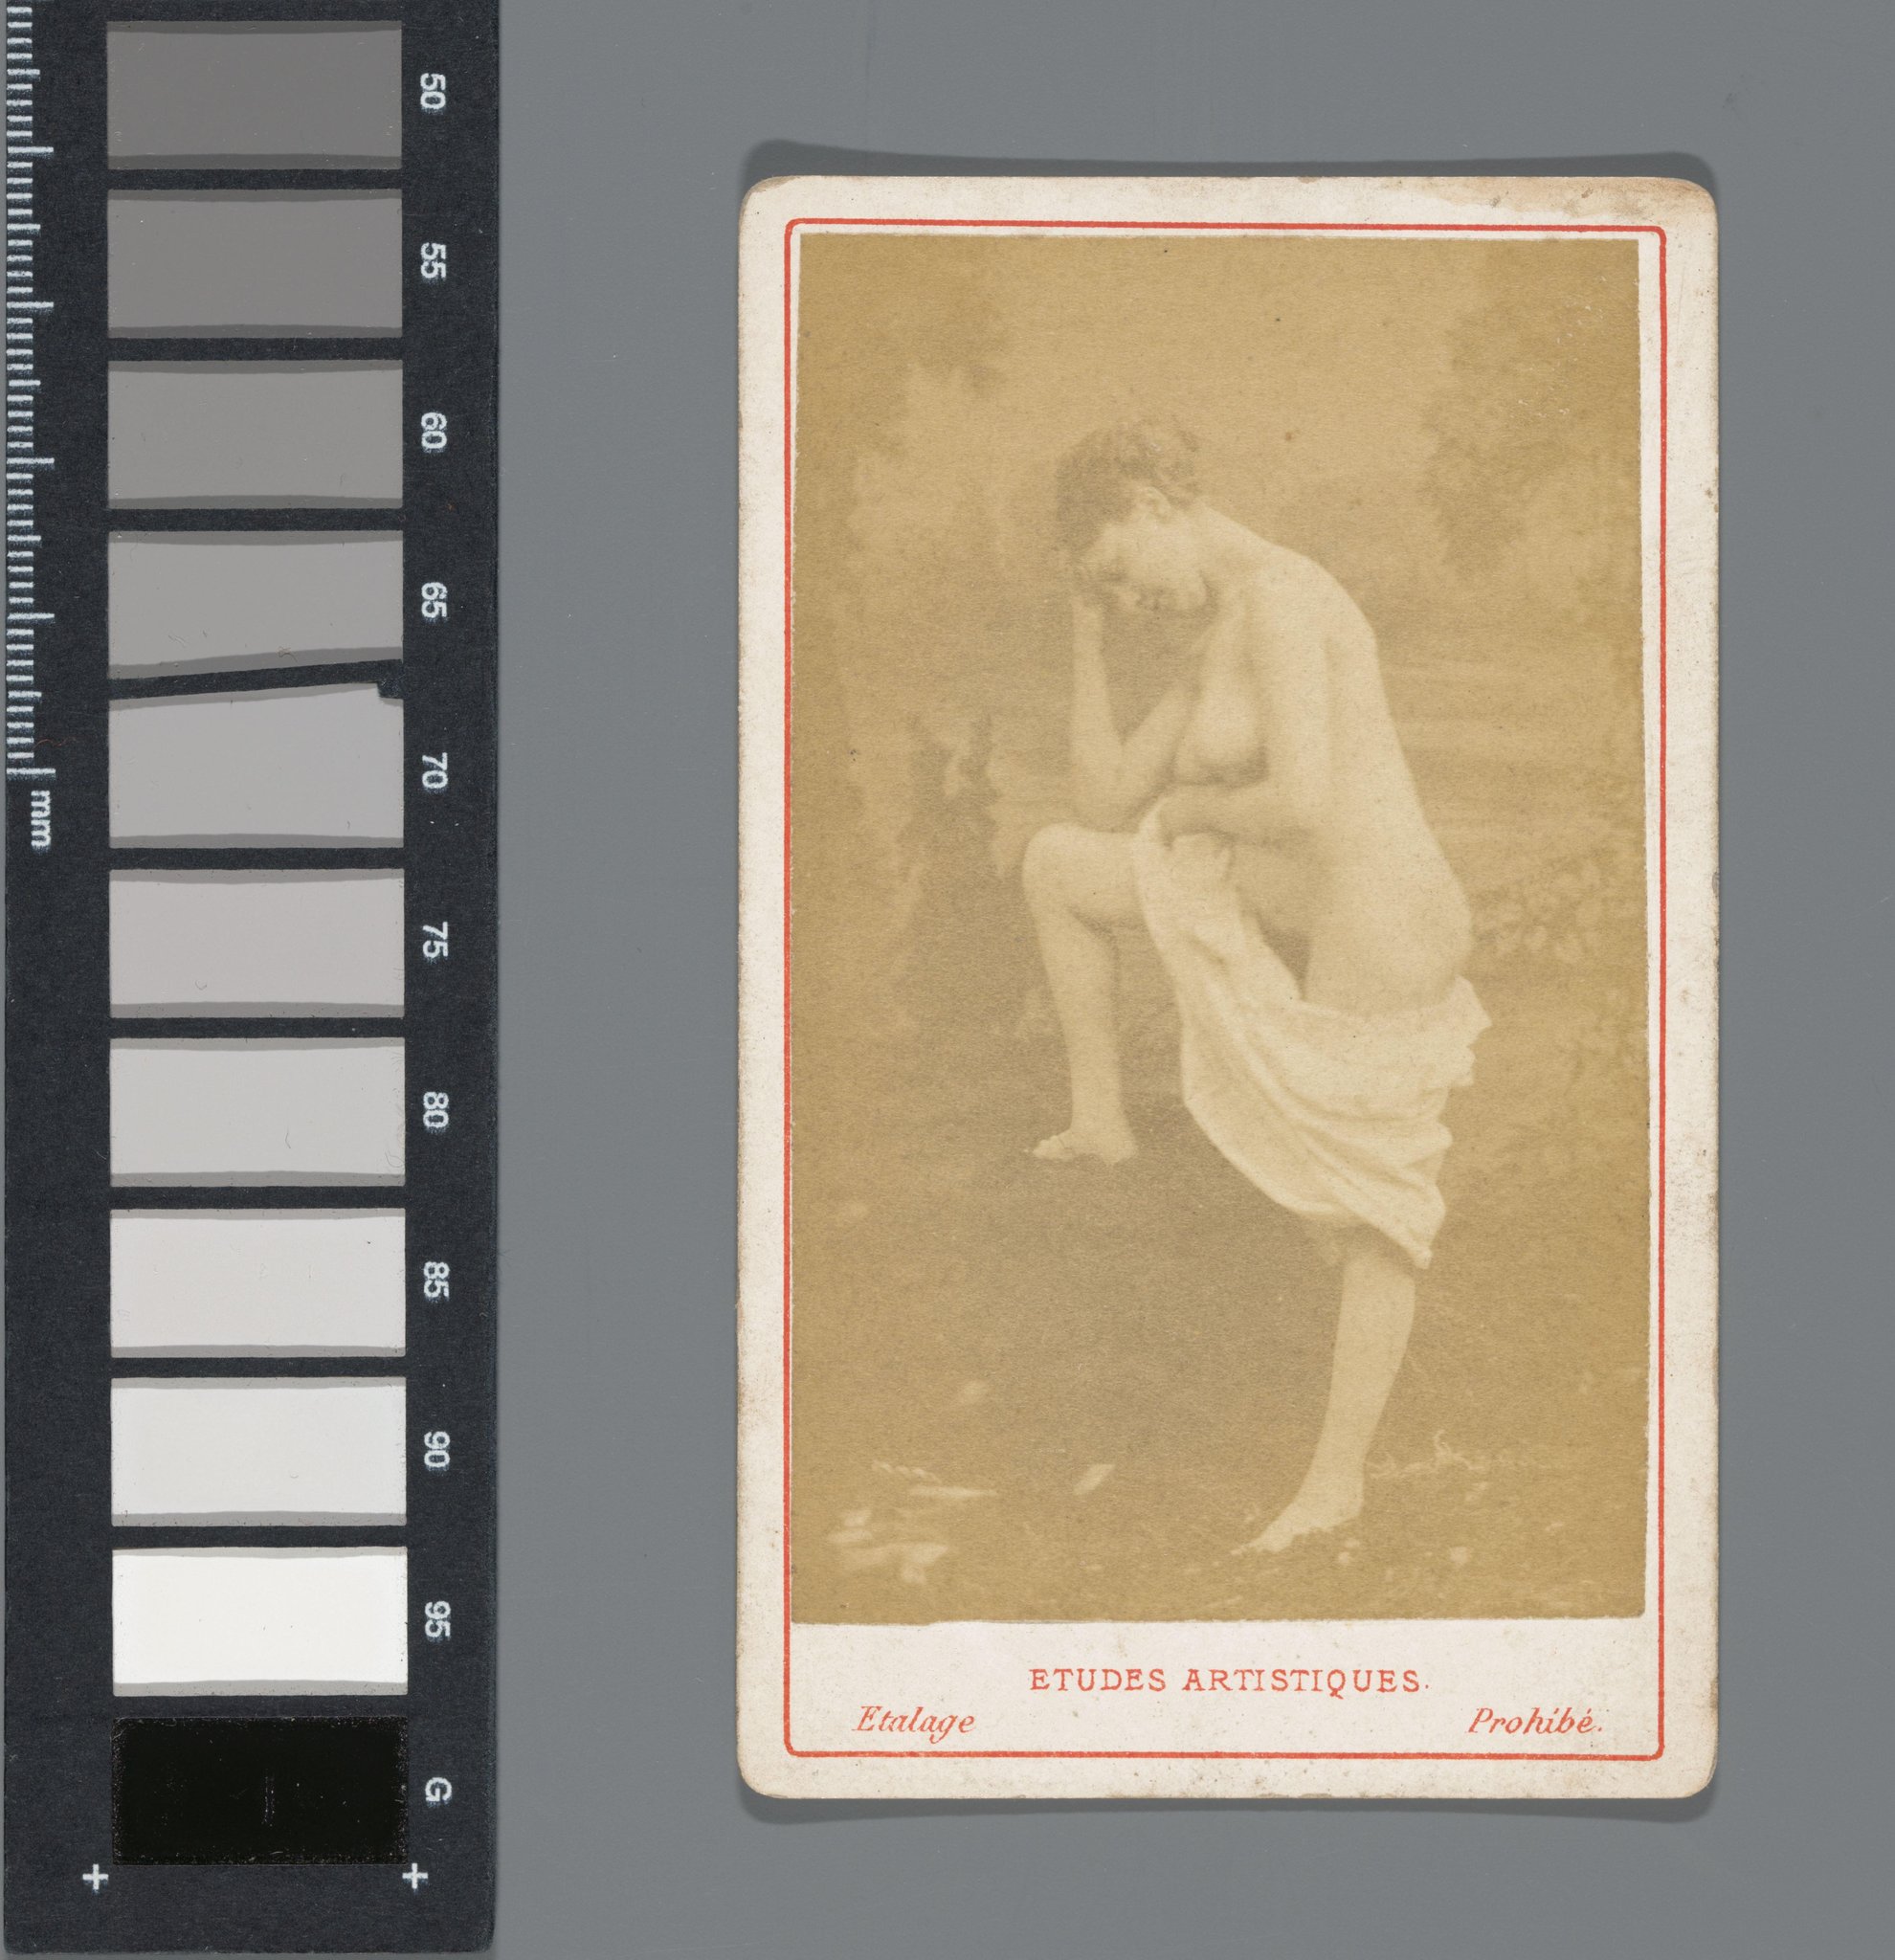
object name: photograph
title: Etudes artistiques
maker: Anonymous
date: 1870-1875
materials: cardboard, paper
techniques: albumen print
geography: france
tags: standing figure - aa - female human figure, france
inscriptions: inscription: ‘Études artistiques / Étalage Prohibé’